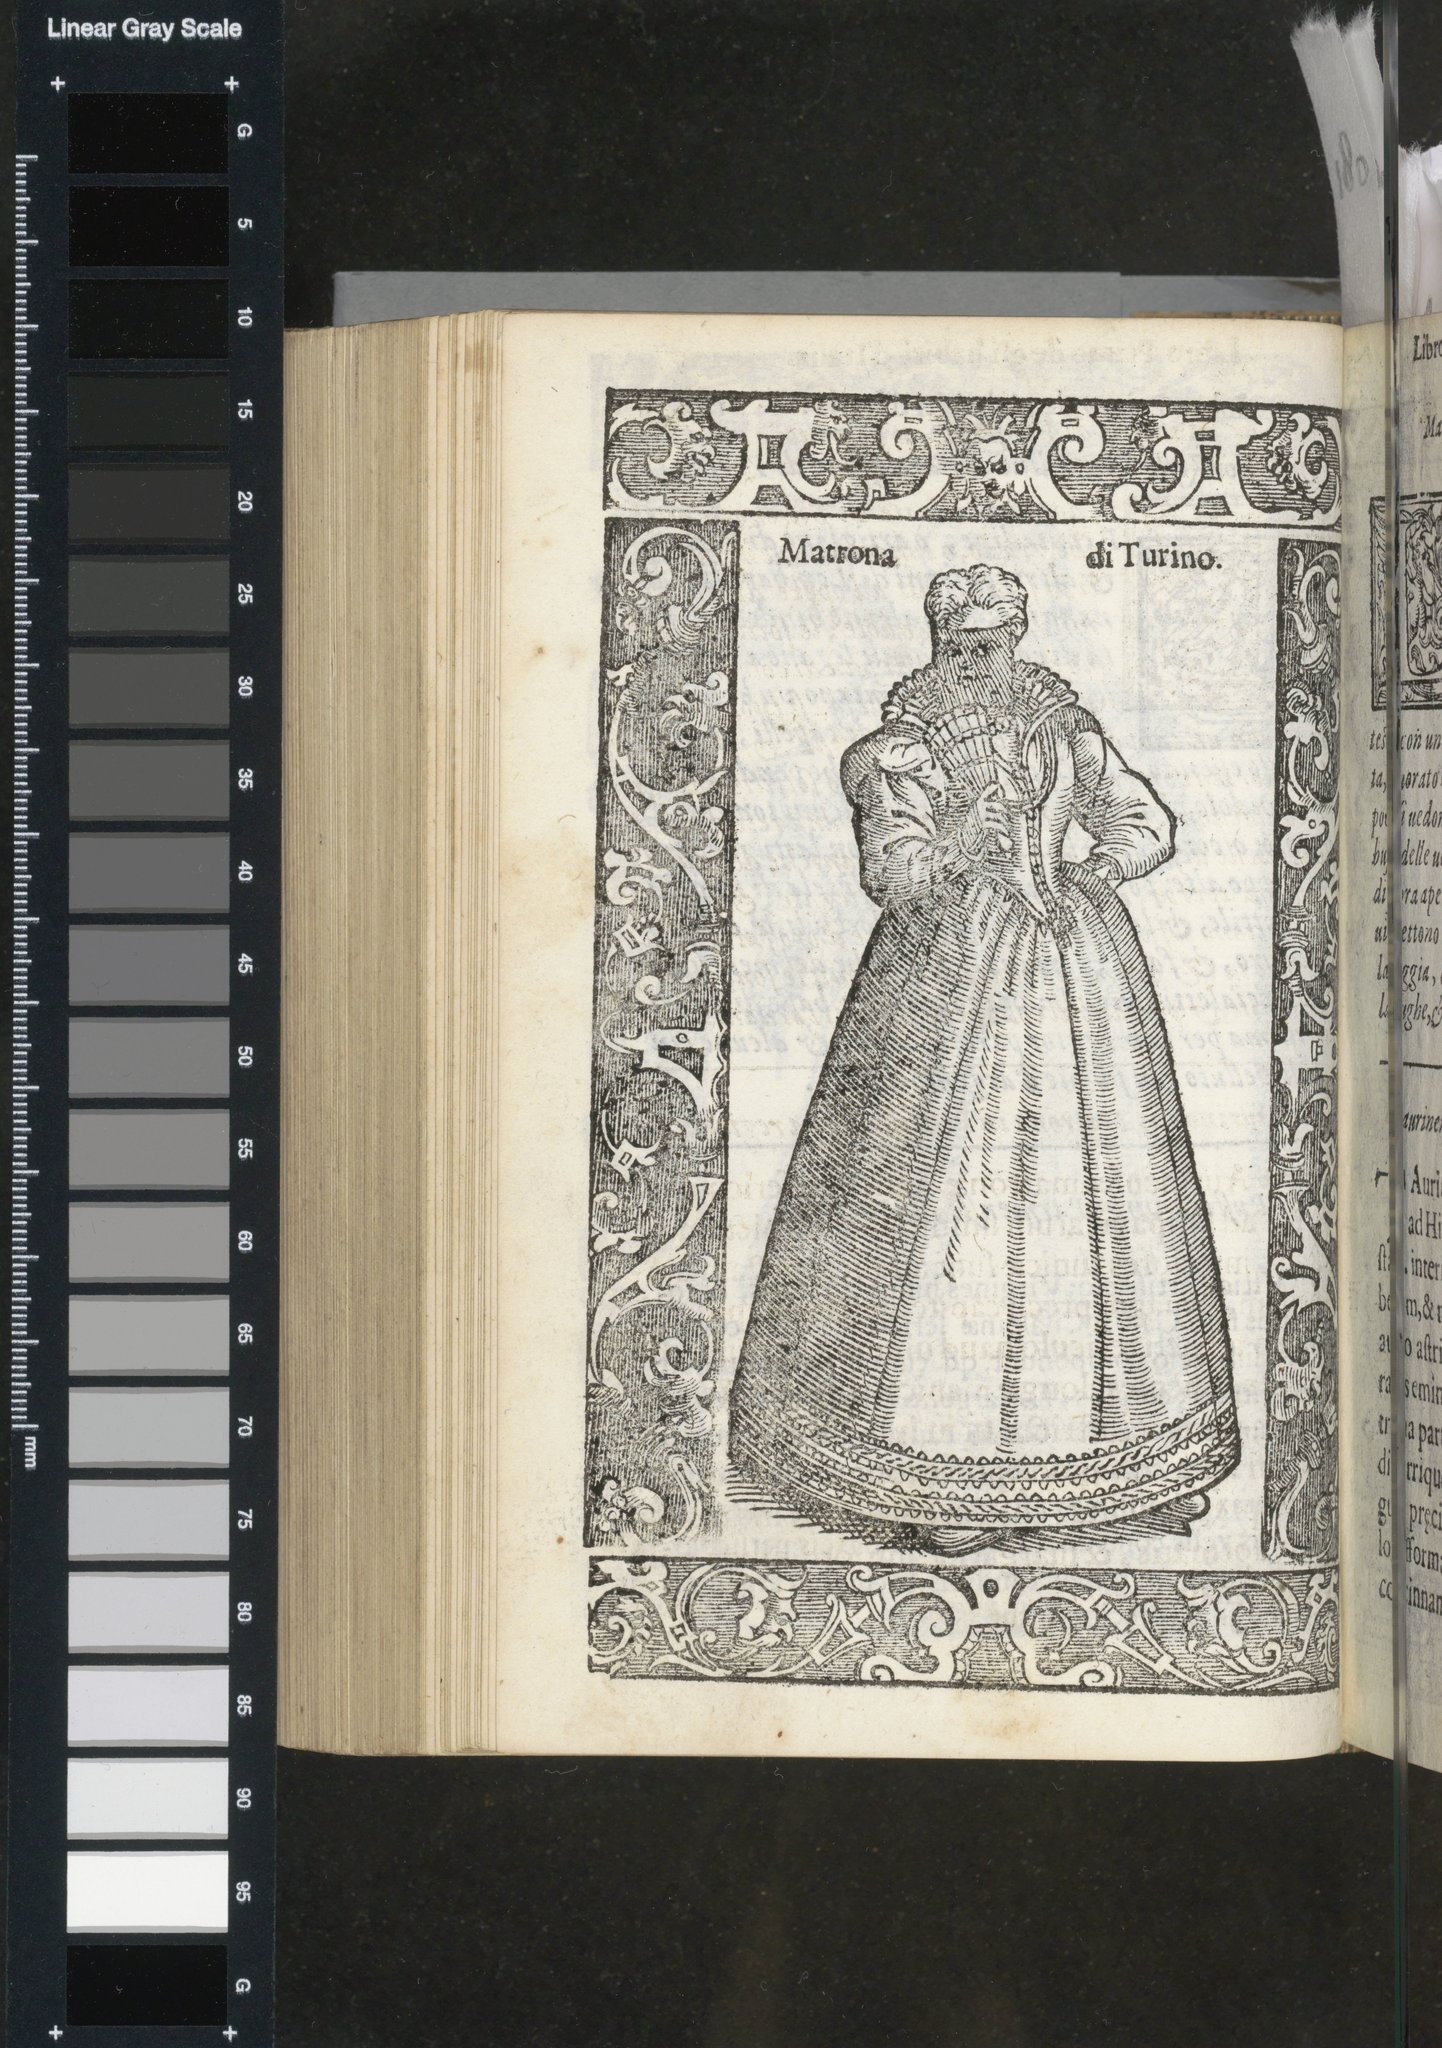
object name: costume print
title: Habiti antichi, et moderni di tutto il mondo...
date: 1598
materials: paper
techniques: woodcut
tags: fashion plates